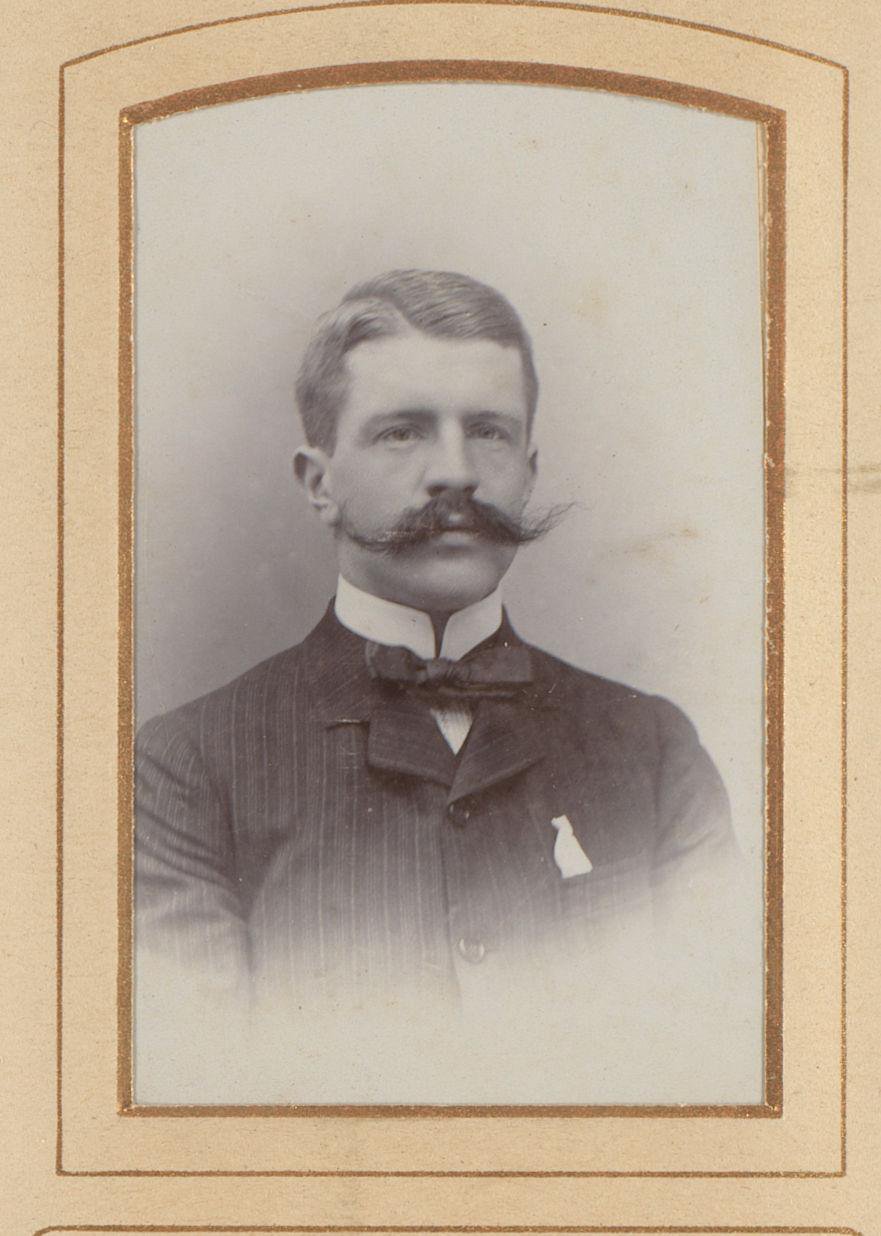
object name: album leaf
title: Portret van een man met snor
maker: Anonymous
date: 1890-1920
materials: cardboard, photographic support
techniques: collodion silver print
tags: moustache, historical persons